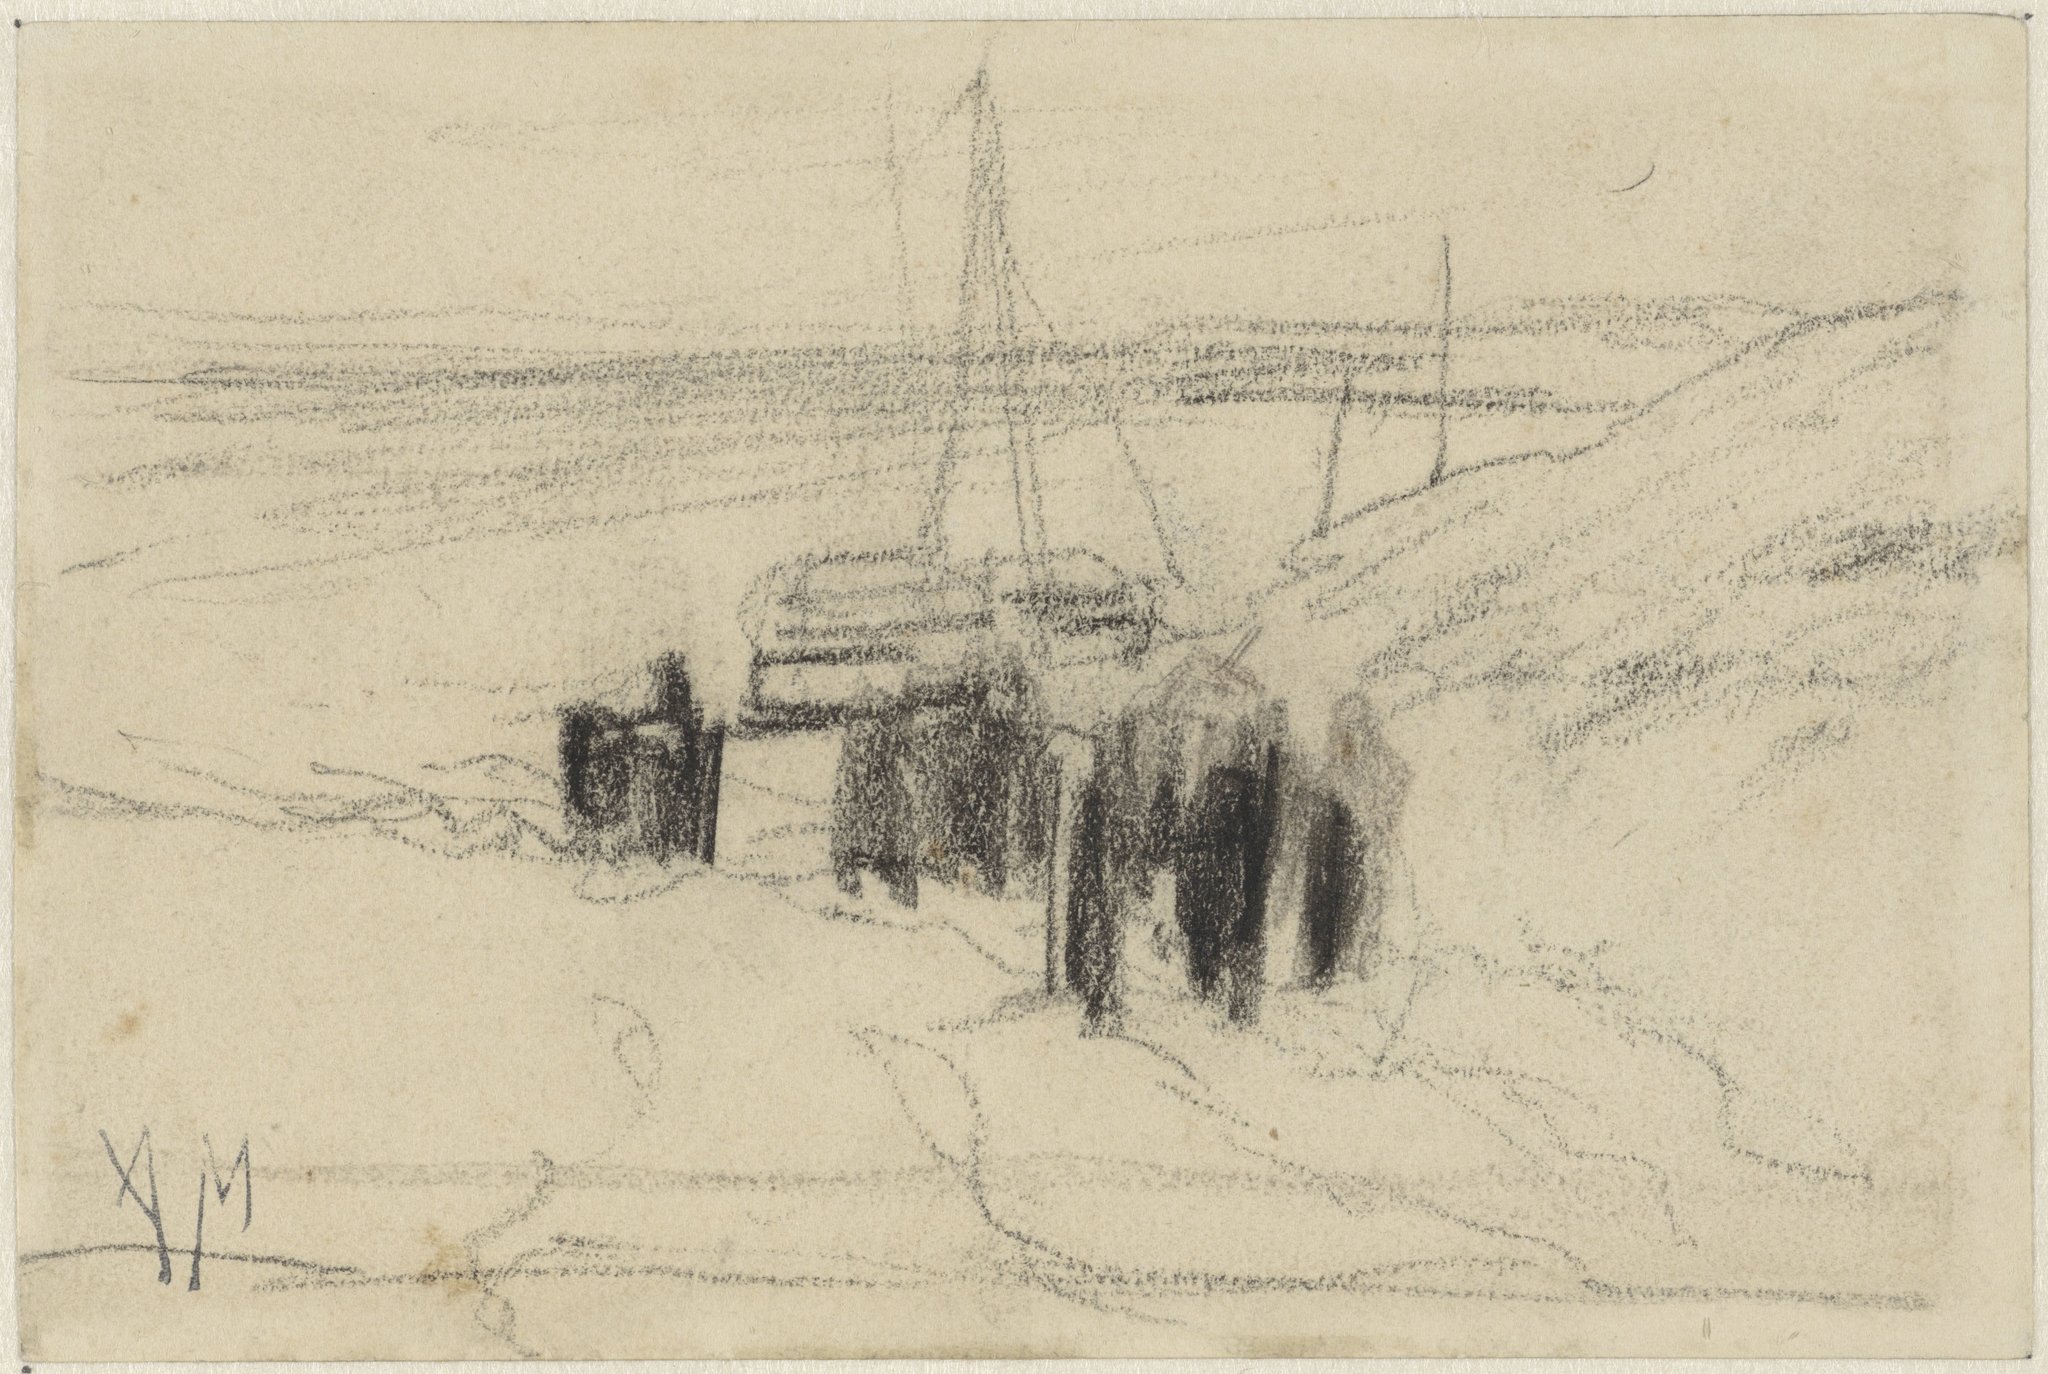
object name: drawing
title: Grazende schapen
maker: anton mauve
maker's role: draughtsman, painter, print maker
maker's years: 1838-1888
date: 1848-1888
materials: chalk, paper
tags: sheep